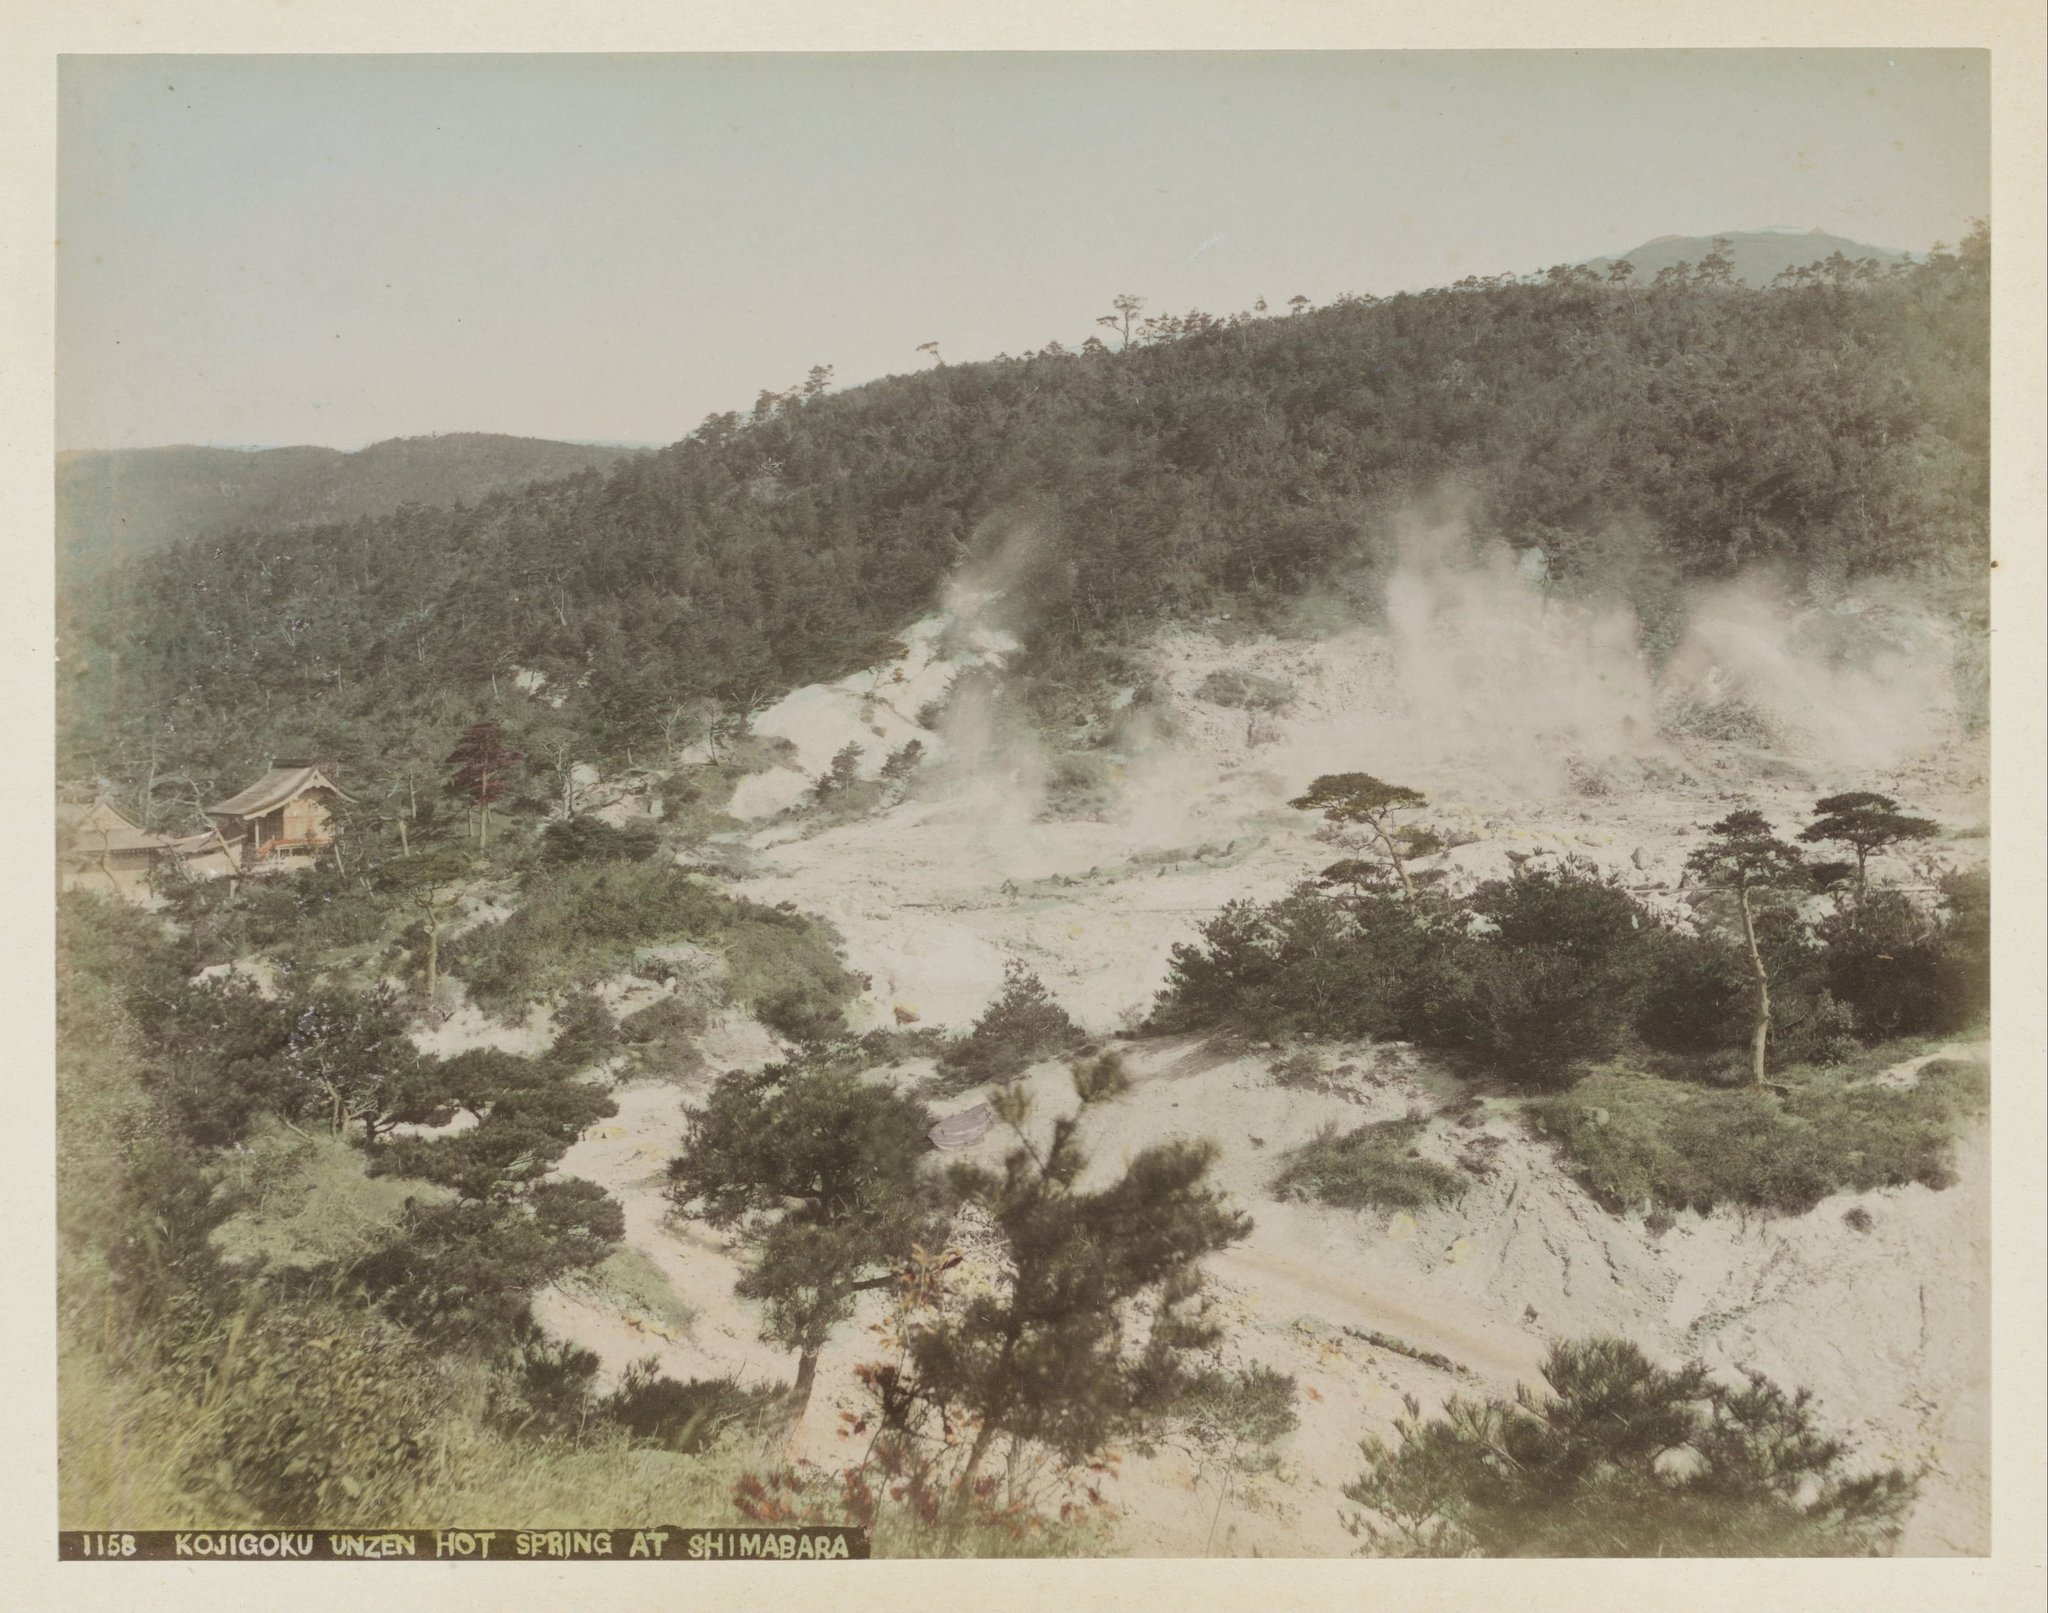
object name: photograph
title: Gezicht op de warmwaterbronnen van Kojigoku Unzen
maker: Anonymous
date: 1870-1900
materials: paper, photographic support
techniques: albumen print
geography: unzen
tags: smoke, trees, hot spring, geyser, (high) hill, travelling; tourism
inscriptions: negative number: ‘1158’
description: Onderdeel van Fotoalbum met 50 foto's van bezienswaardigheden in Japan.